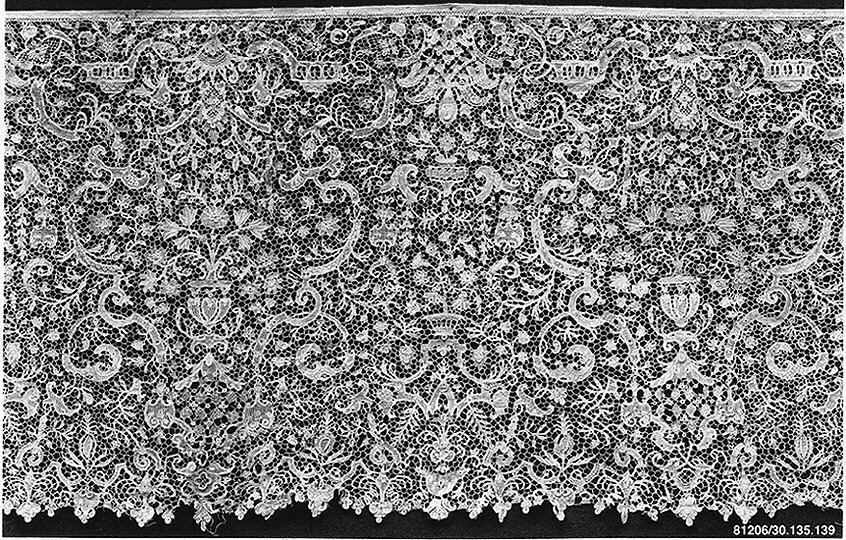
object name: flounce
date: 1667-1700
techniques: lace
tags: flowers